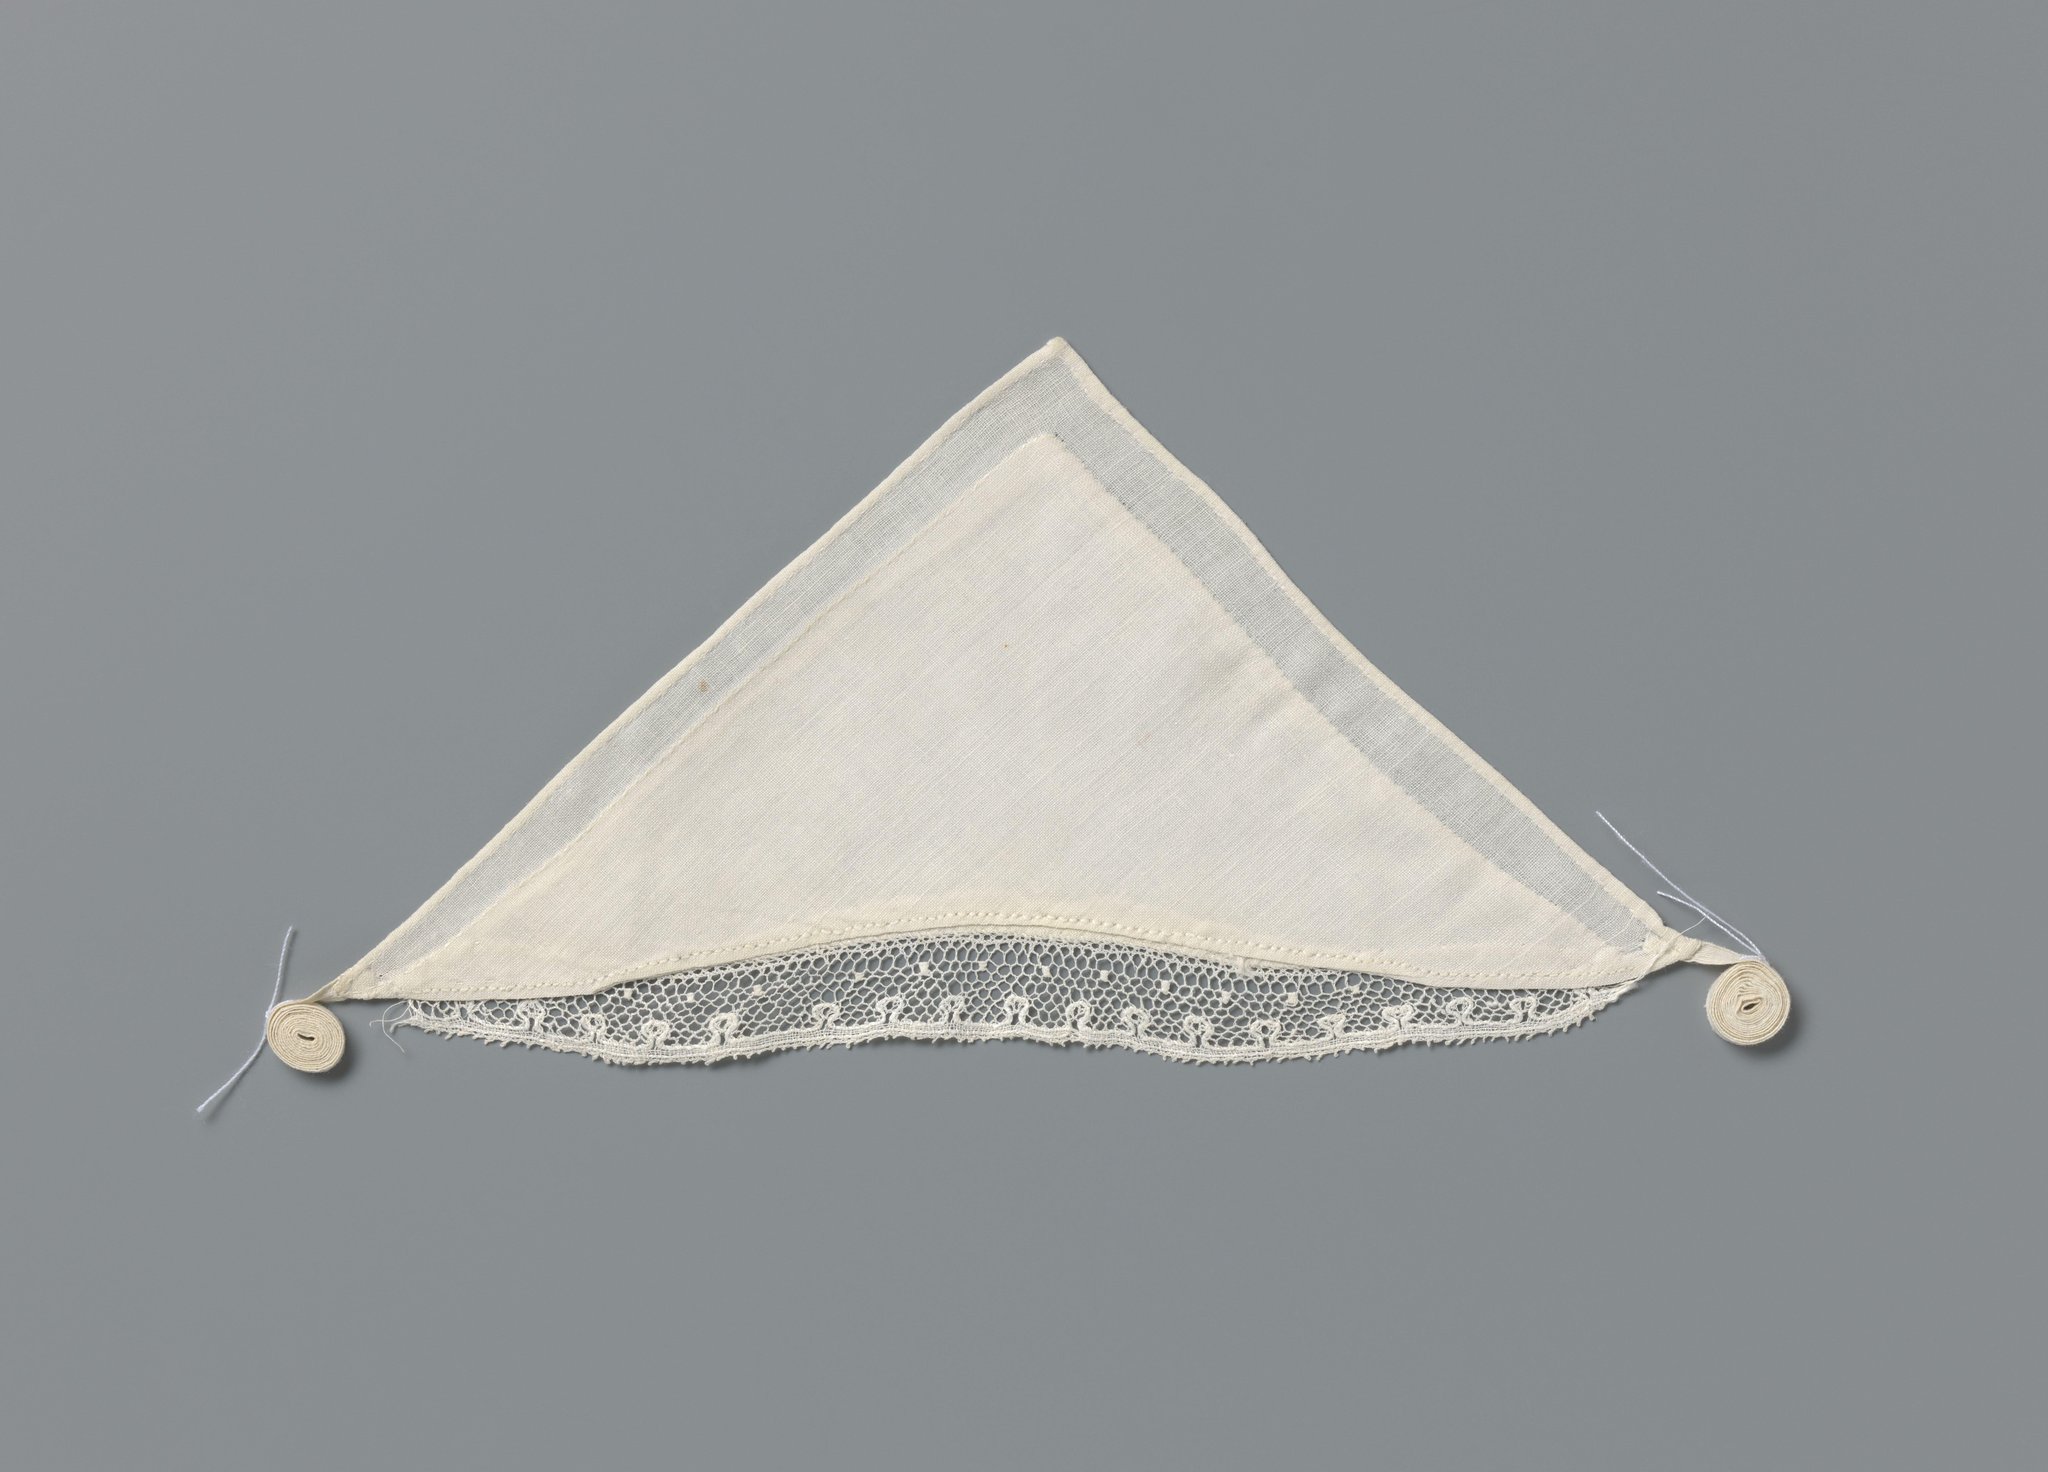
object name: fontaneldoek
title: Fontaneldoek met een strook Rijsselse kant, met rechte picotrand en enkele moesjes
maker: Anonymous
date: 1785-1800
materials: linen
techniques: lace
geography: europe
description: Fontaneldoekje met een strook Rijsselse kant, met rechte picotrand en enkele moesjes.